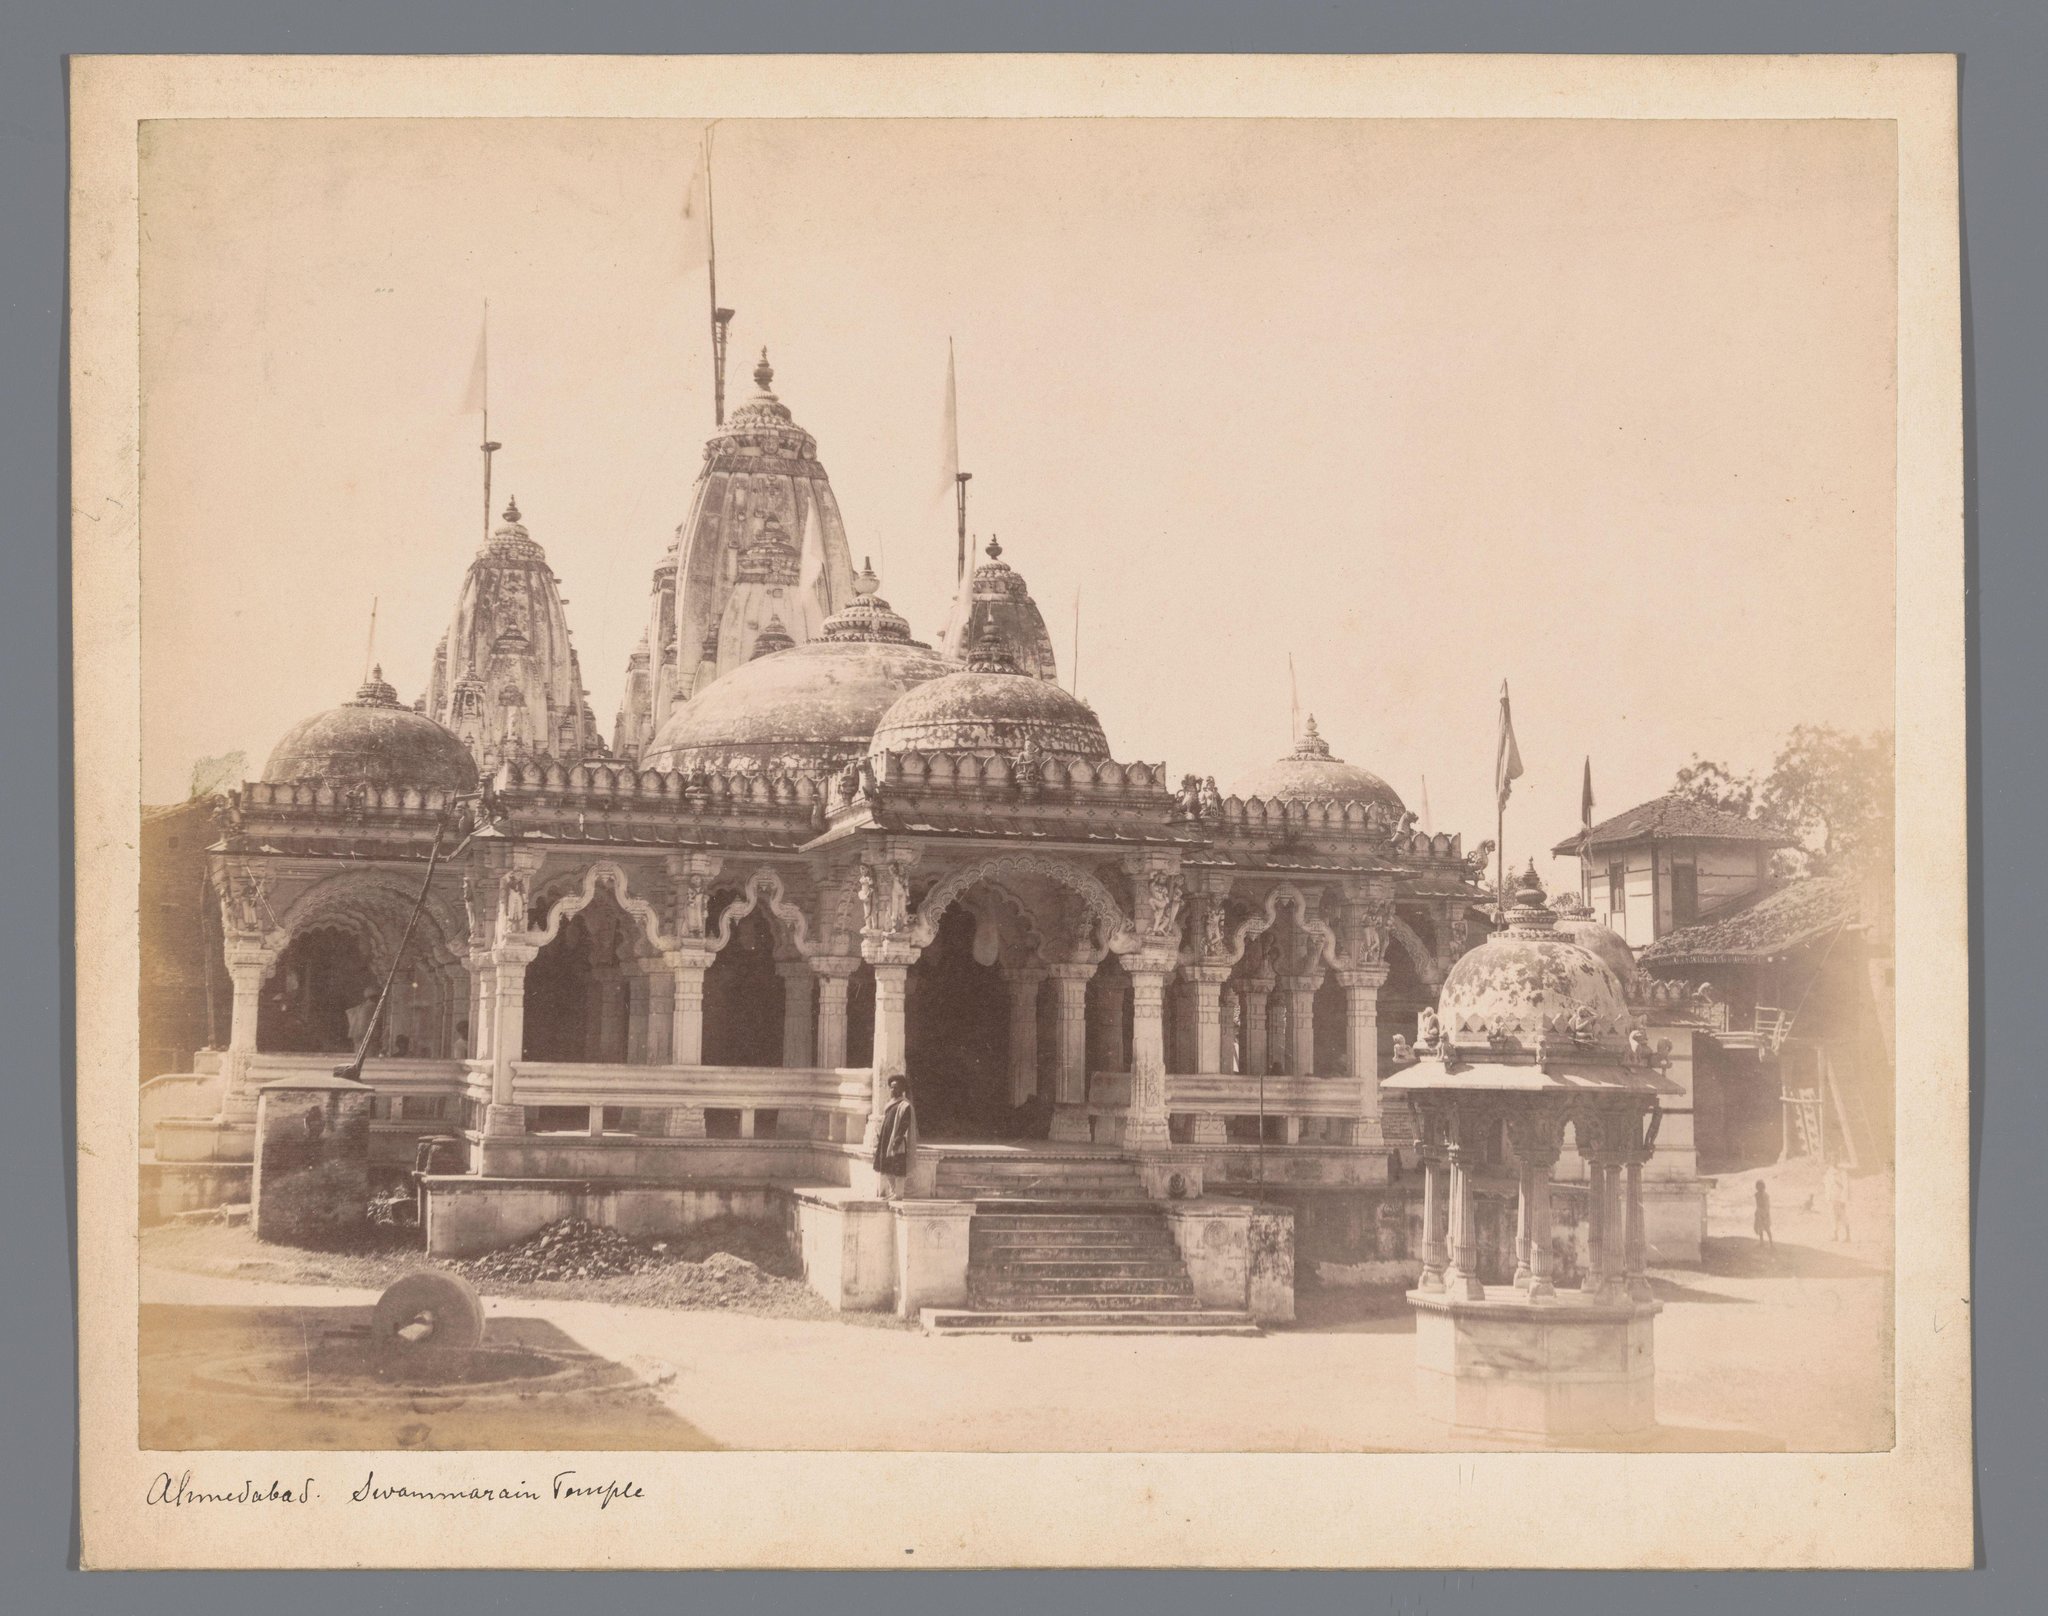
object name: photograph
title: Swaminarayan Temple at Ahmedabad, Gujarat, India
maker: Anonymous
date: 1865-1890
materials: cardboard, paper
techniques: albumen print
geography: ahmedabad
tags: temple, shrine ~ hinduism, buddhism, jainism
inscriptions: title: ‘Ahmedabad. Swamnarain Temple’, number: ‘23’